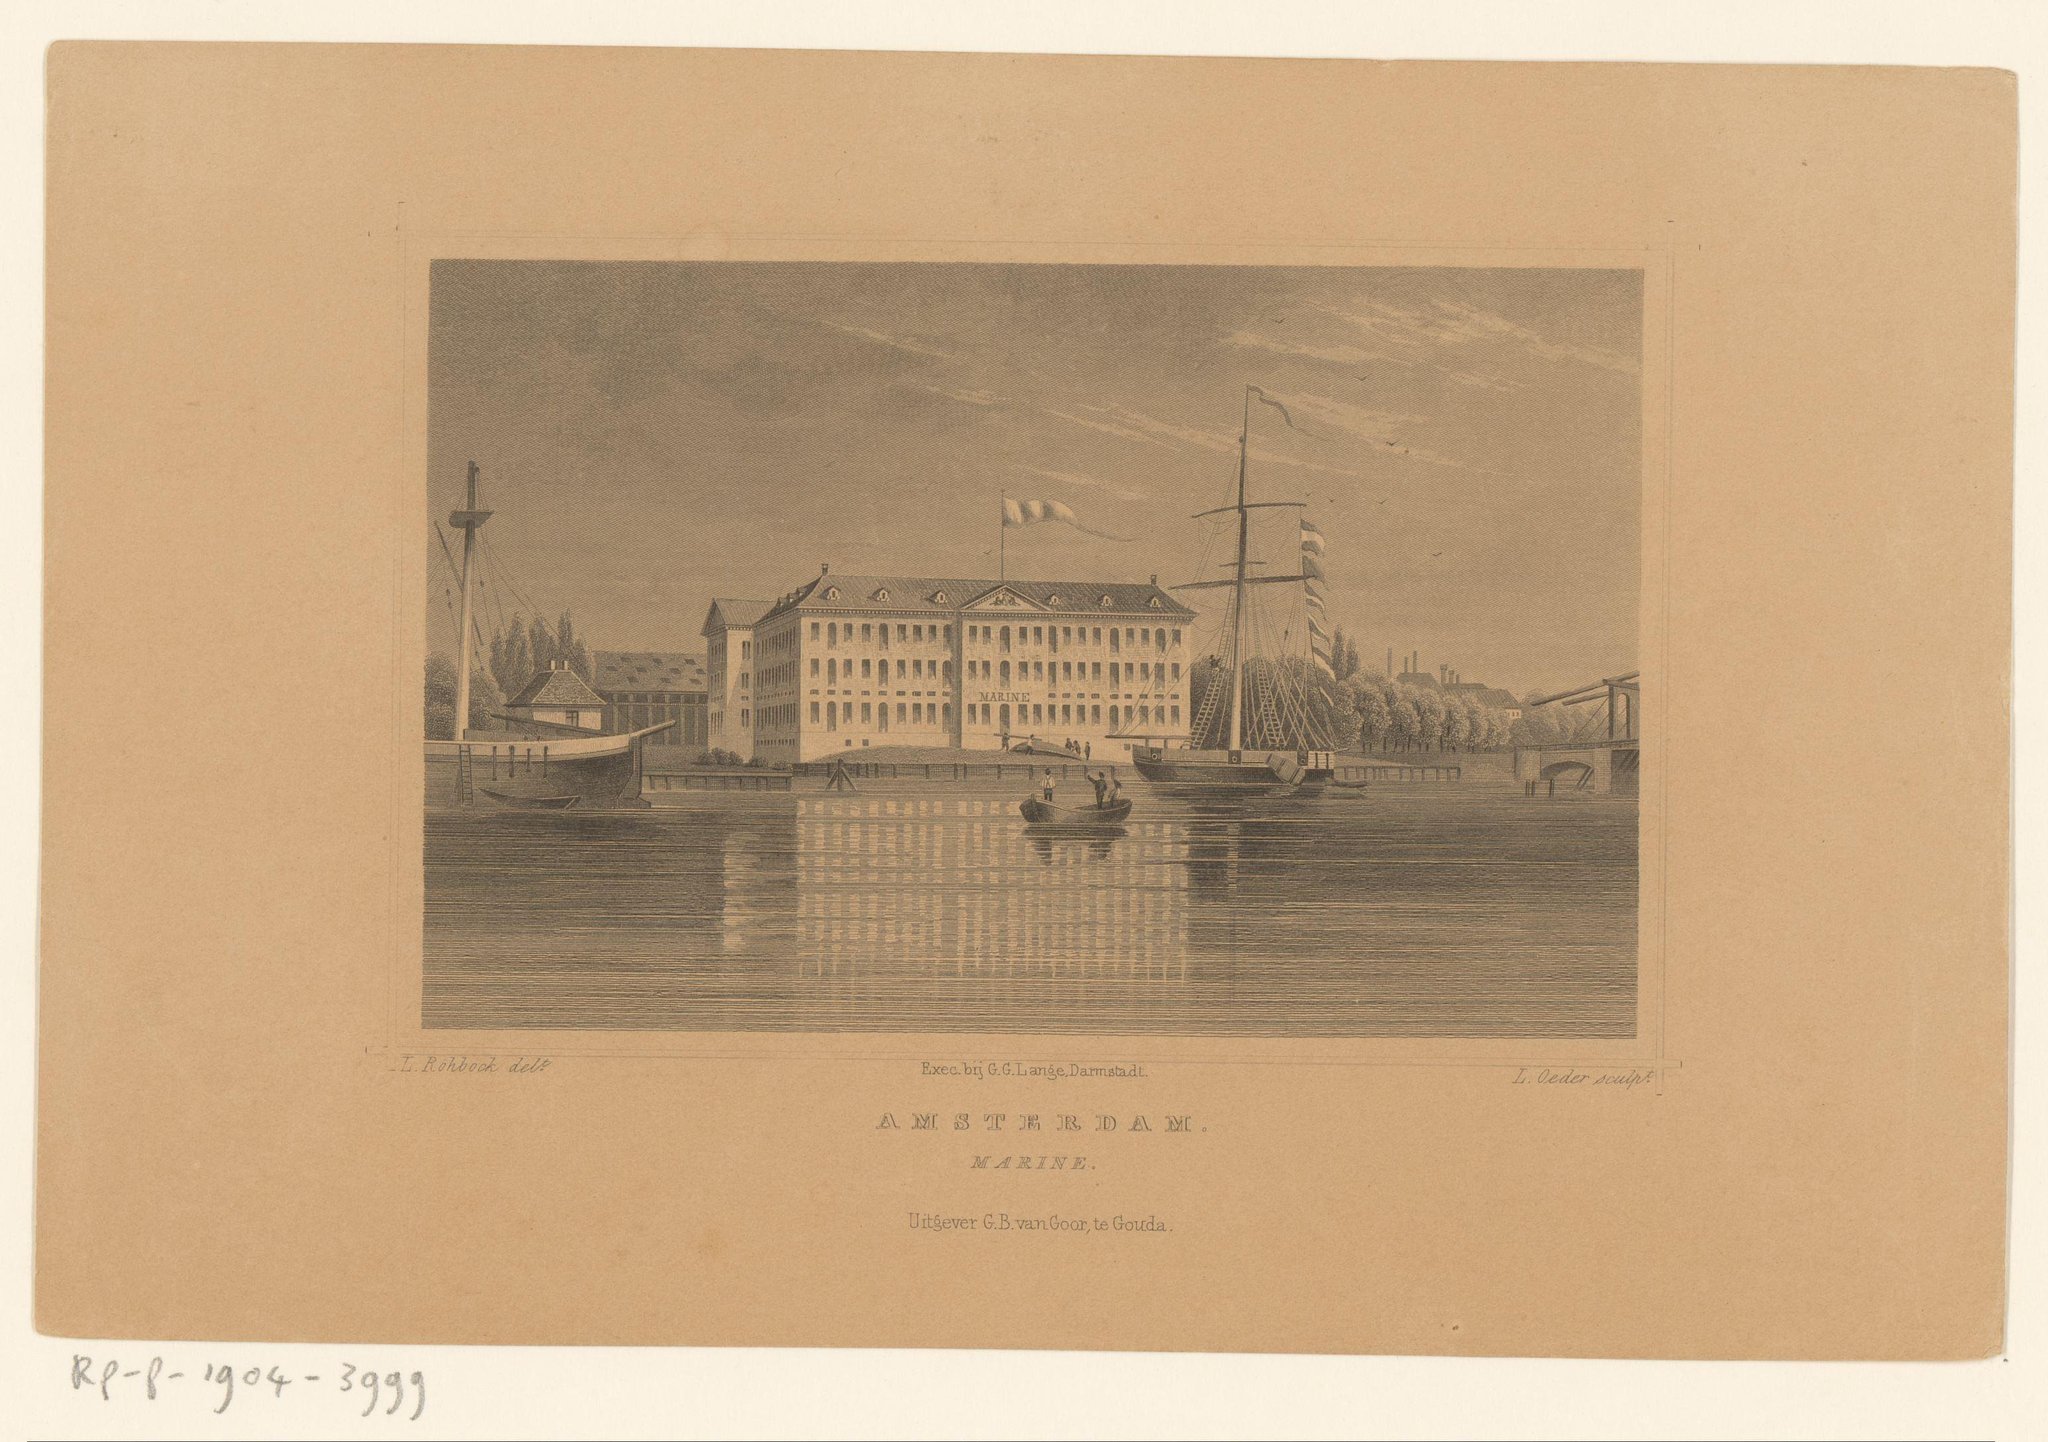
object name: print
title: Gezicht op 's Lands Zeemagazijn in Amsterdam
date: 1863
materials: paper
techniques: engraving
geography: darmstadt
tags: city-view, and landscape with man-made constructions, amsterdam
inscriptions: collector's mark: Lugt 2228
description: Prent afkomstig uit: Terwen, J.L. Het koningrijk der Nederlanden voorgesteld in eene reeks van 136 naar de natuur geteekende schilderachtige gezigten. Darmstadt: G.G. Lange, 1863.